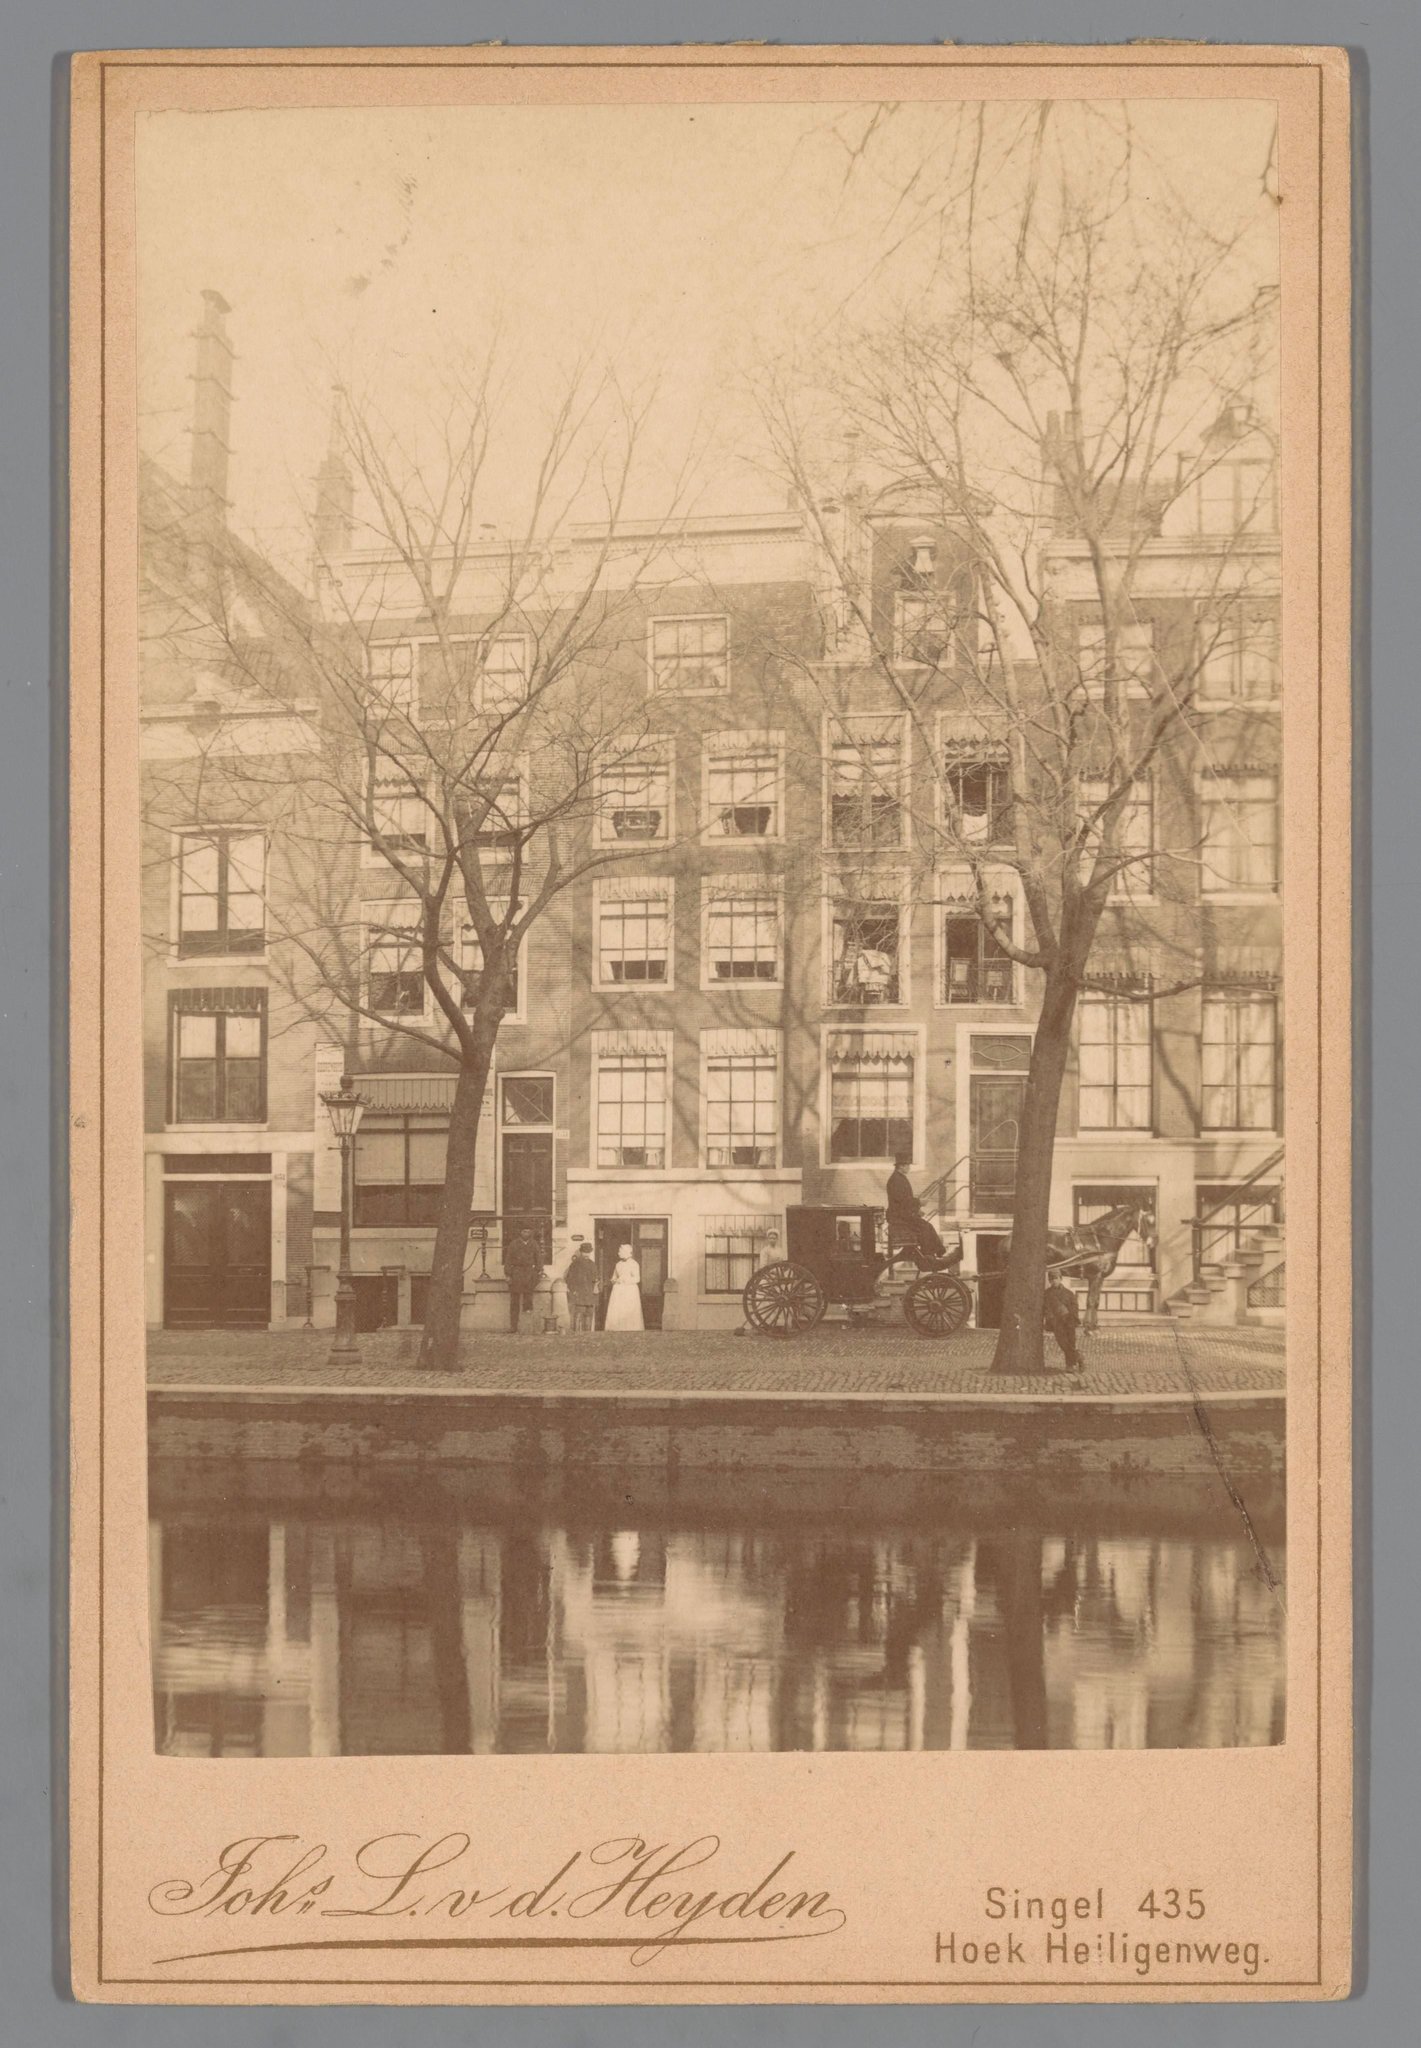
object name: cabinet photograph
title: Koets voor huizen aan de Singel in Amsterdam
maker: johannes leonardus van der heijden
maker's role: fotograaf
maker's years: 1856-1937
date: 1880-1940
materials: cardboard, photographic support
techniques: collodion silver print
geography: amsterdam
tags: canals, waters (in city), street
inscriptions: address: ‘Singel 435, Hoek Heiligenweg.’